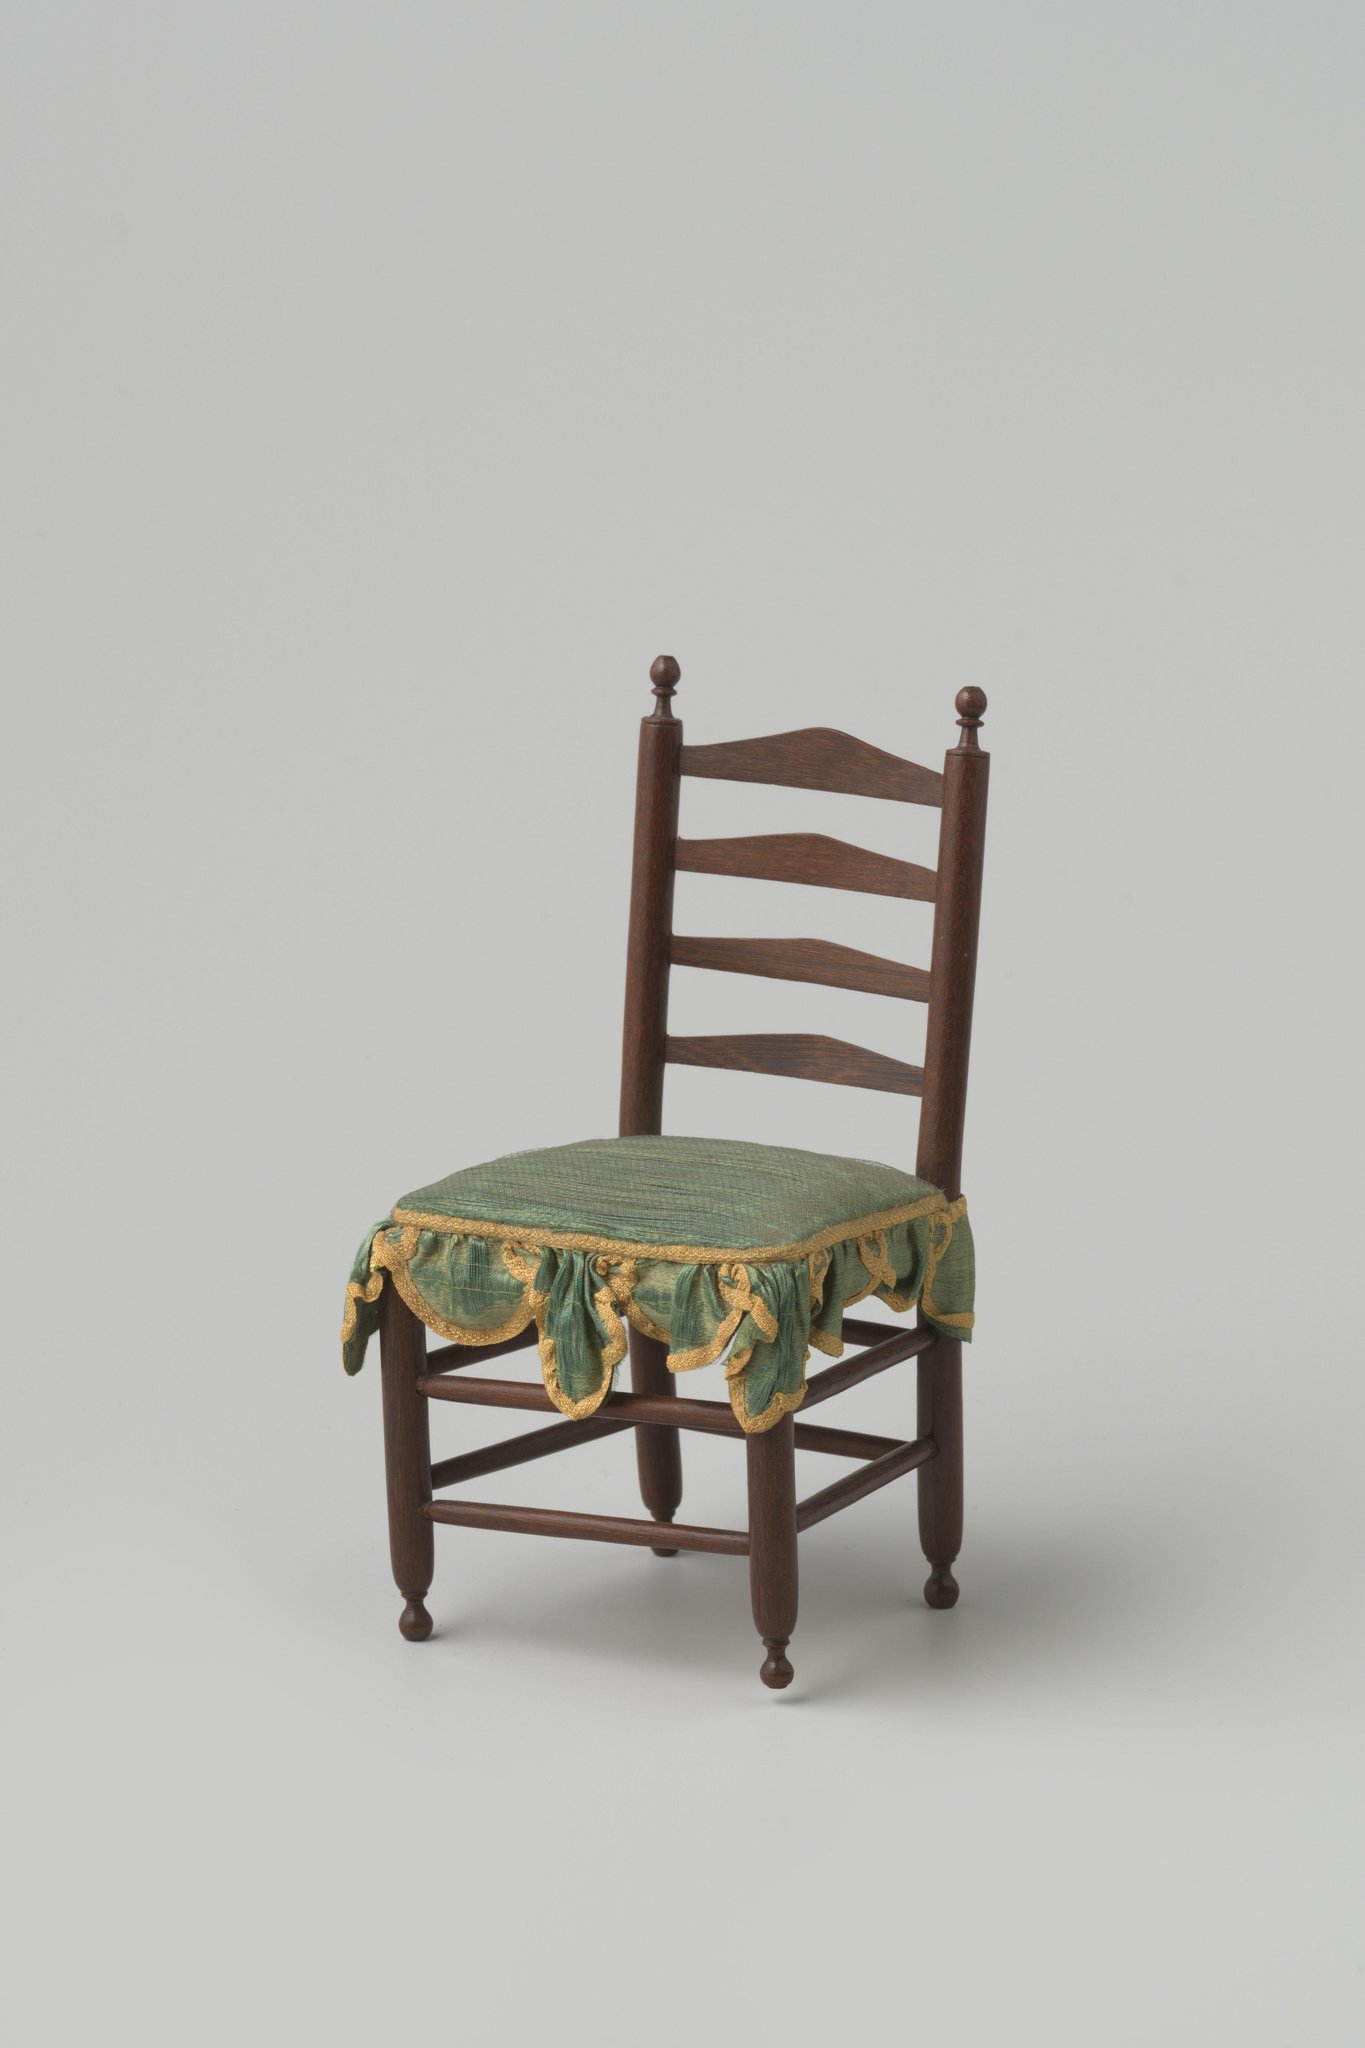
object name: knopstoel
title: Knopstoel vervaardigd van hardhout met gladde, gedraaide stijlen en dwarsregels, voorpoten en achterstijlen eindigend in fijn gedraaide knoppen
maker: Anonymous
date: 1690-1710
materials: wood, silk, fiber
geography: amsterdam